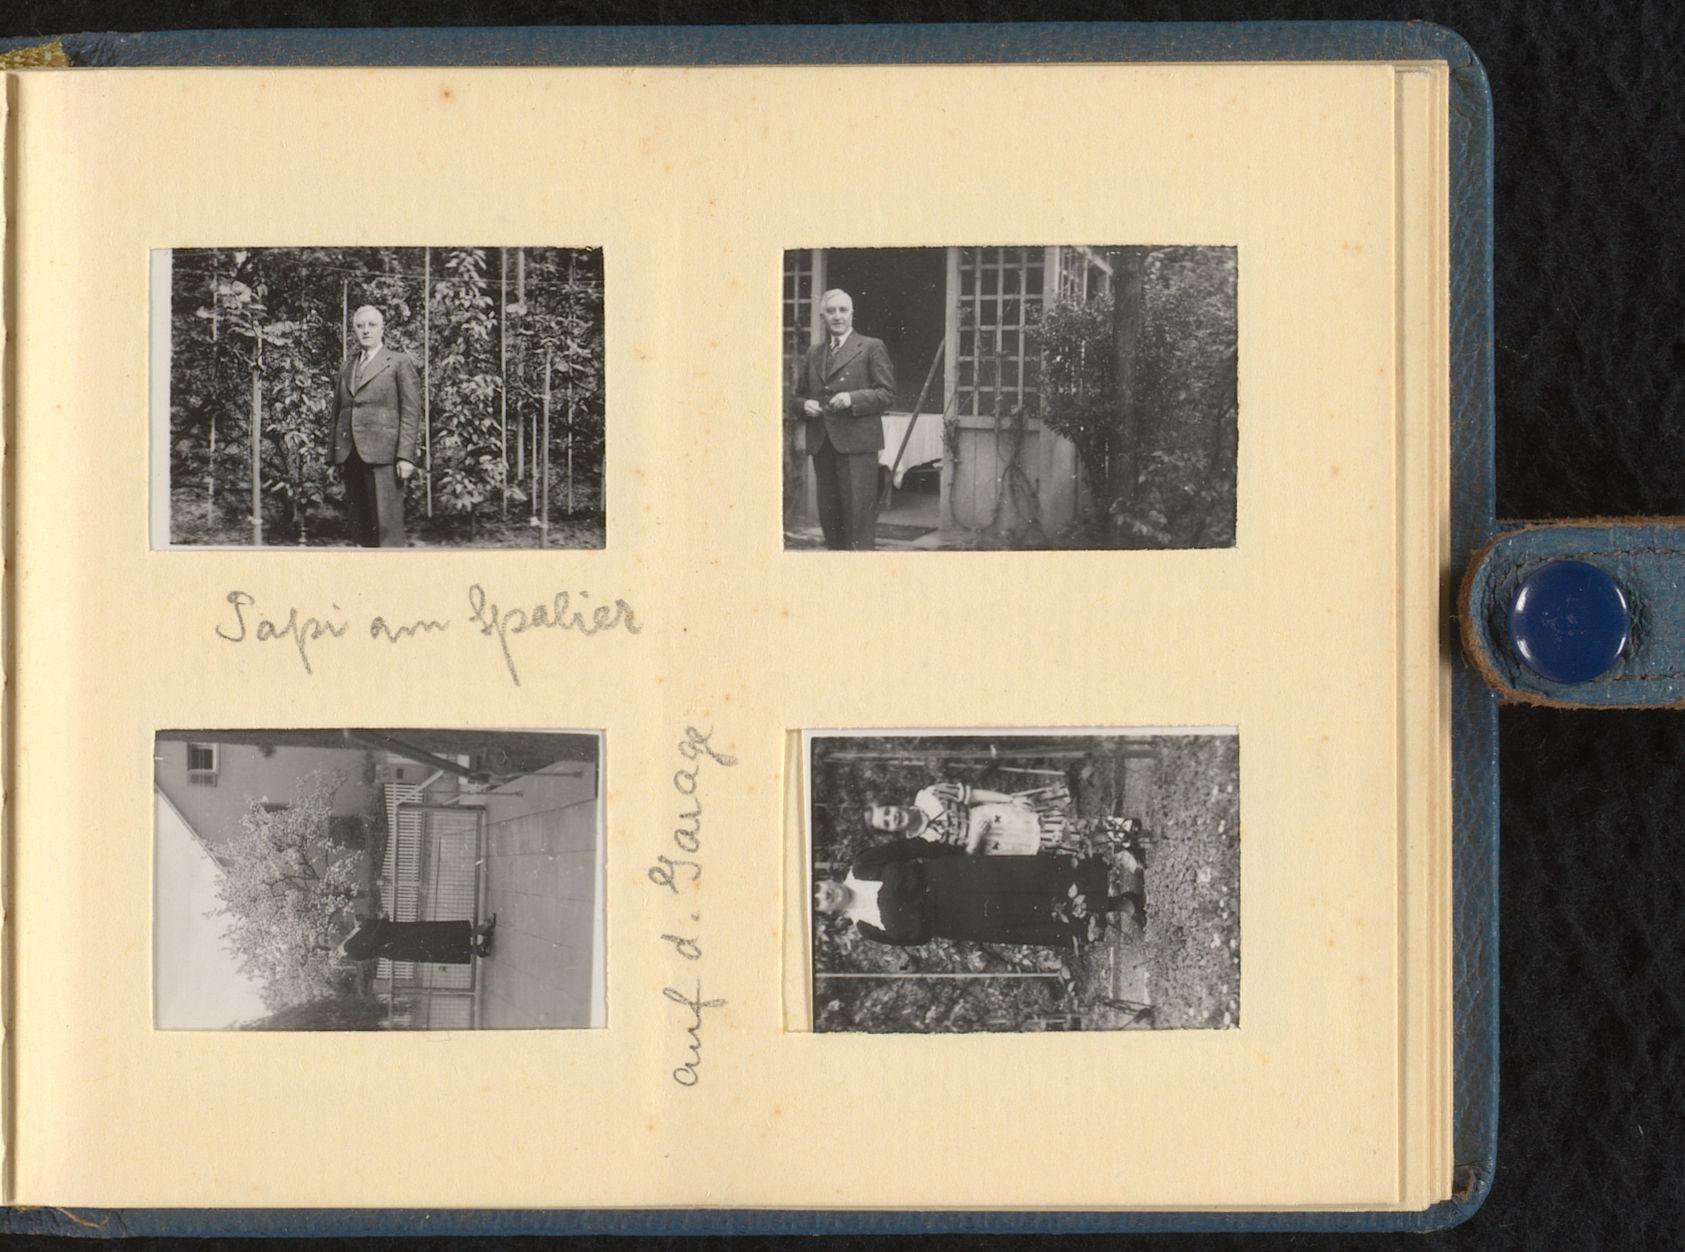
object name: photograph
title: Isabel Wachenheimer in de tuin van de woning van de familie Wachenheimer aan de Hauptmannsreute met haar ouders Else Wachenheimer-Moos en Eugen Wachenheimer, 1936-1937, Stuttgart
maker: else wachenheimer-moos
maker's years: 1895-1944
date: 1936-1937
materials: paper, photographic support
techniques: gelatin silver print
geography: stuttgart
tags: eugen wachenheimer, else wachenheimer-moos, isabel wachenheimer-elon, family life at home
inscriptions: inscription: ‘Papi am Spazier / auf d. Garage’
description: Albumblad bevat vier foto's. Alle foto's van Else Wachenheimer-Moos (als volwassen vrouw), Isabel Wachenheimer (als jong meisje) en Eugen Wachenheimer (in kostuum). Uit klein formaat fotoalbum, blauw lederen omslag met drukknopsluiting. Met foto's in klein formaat.